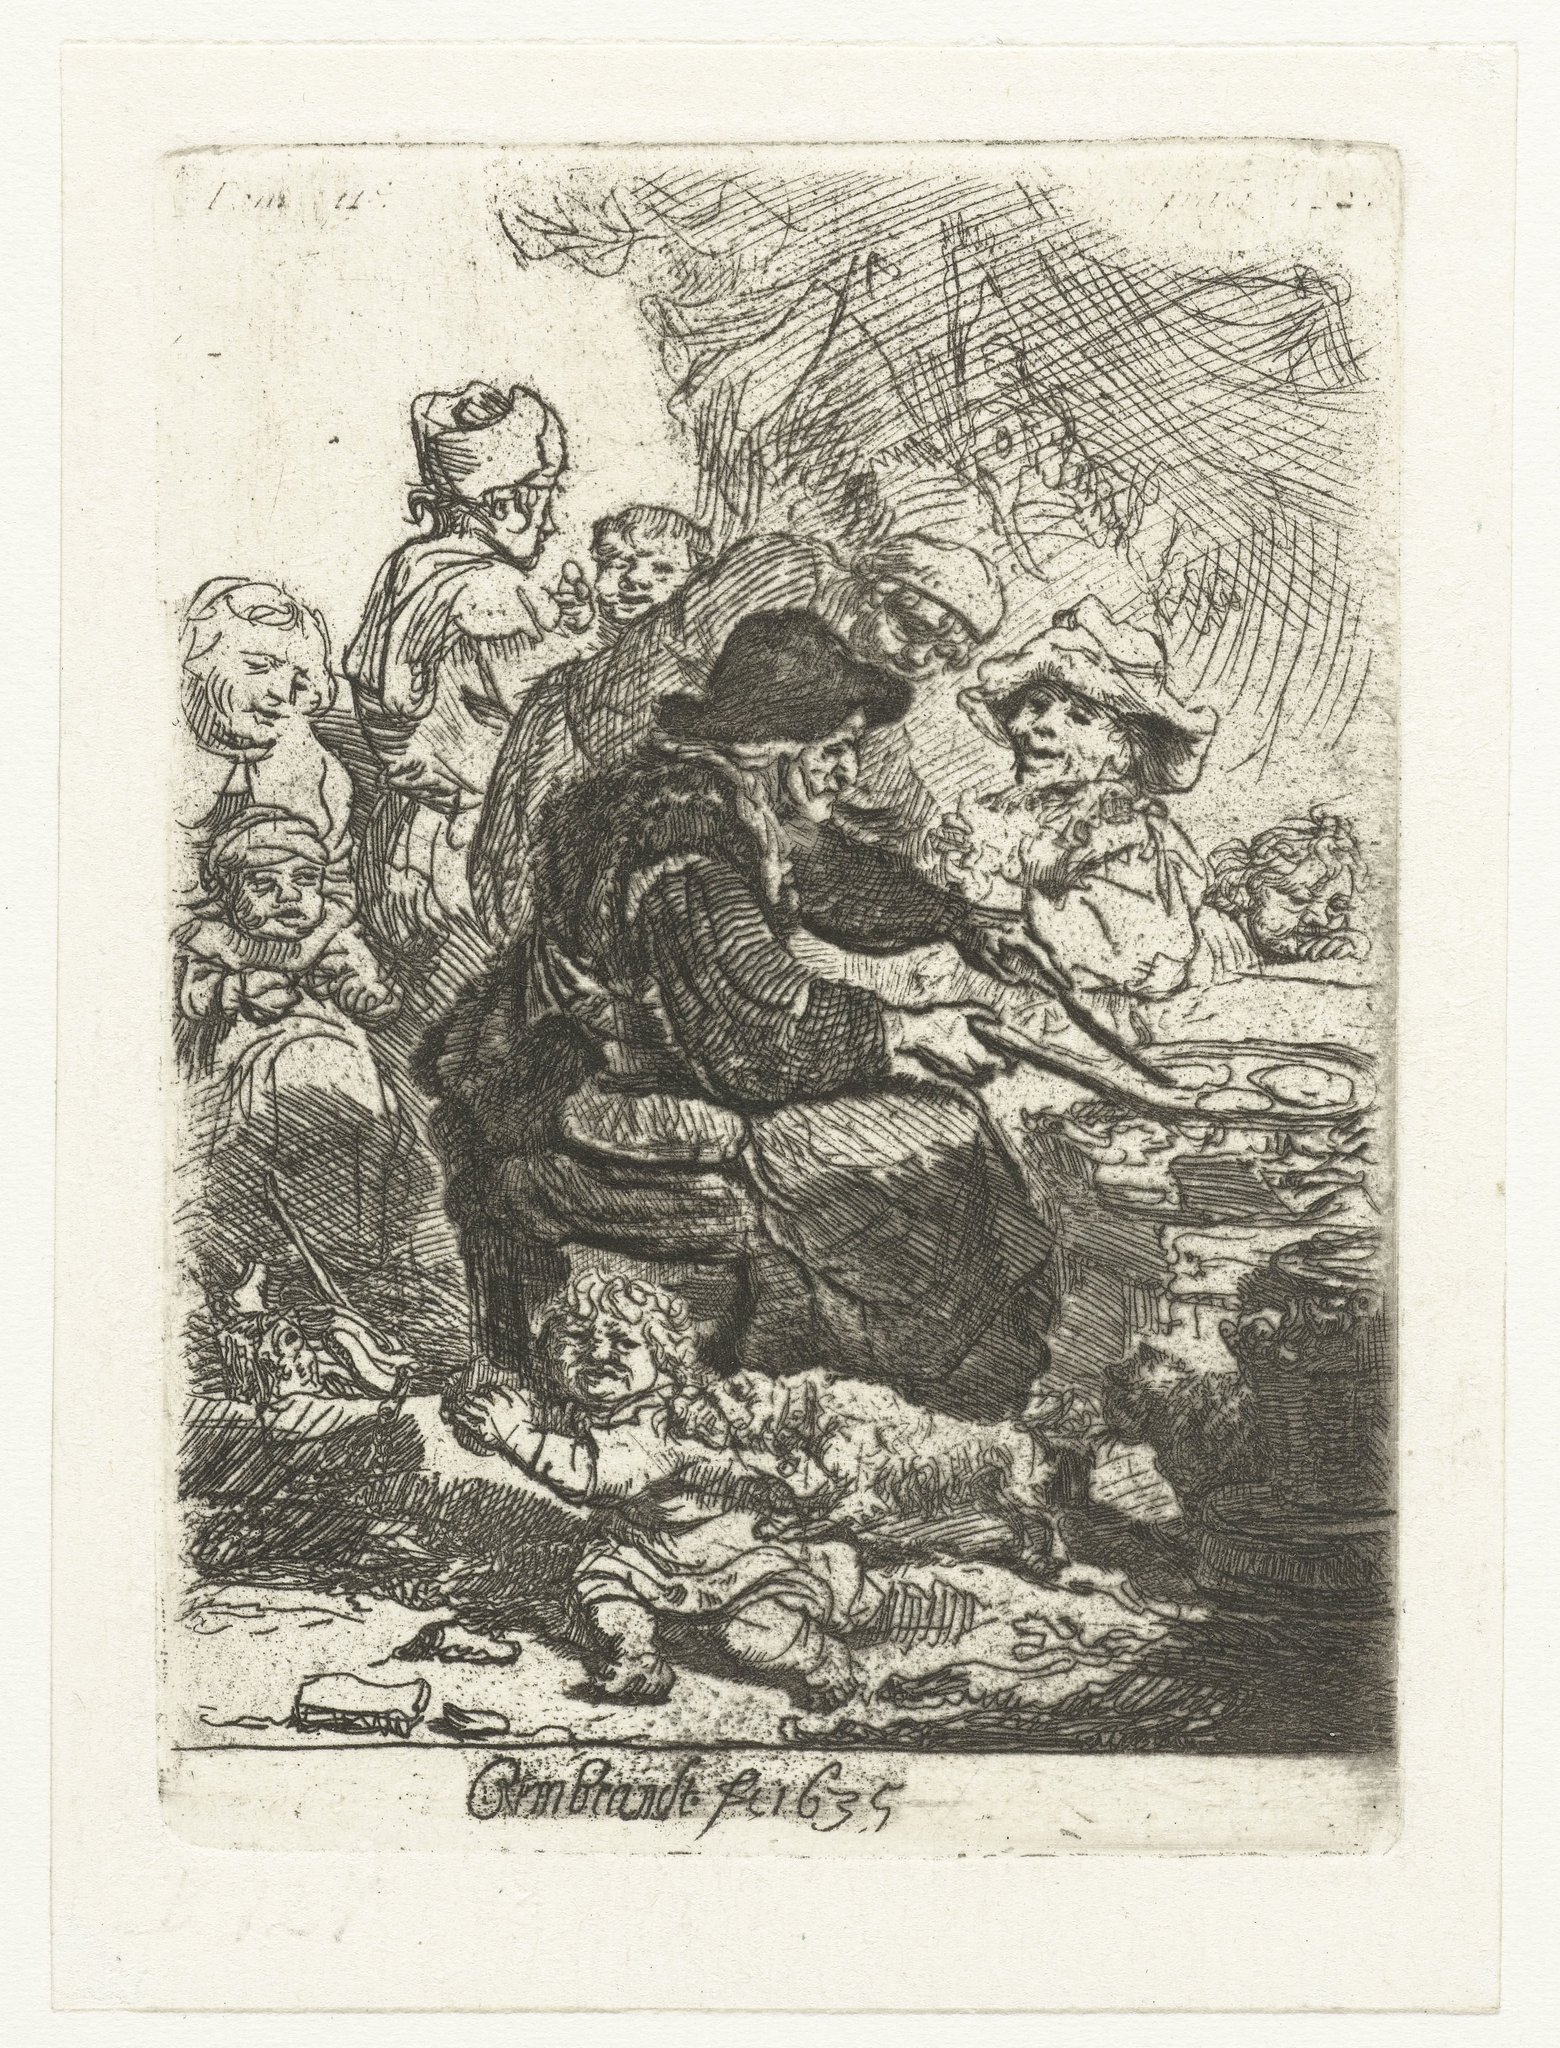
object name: print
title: The pancake woman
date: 1635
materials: paper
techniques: etching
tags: pancakes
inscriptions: signature and date: ‘Rembrandt f. 1635’, inscription: ‘Coppier’